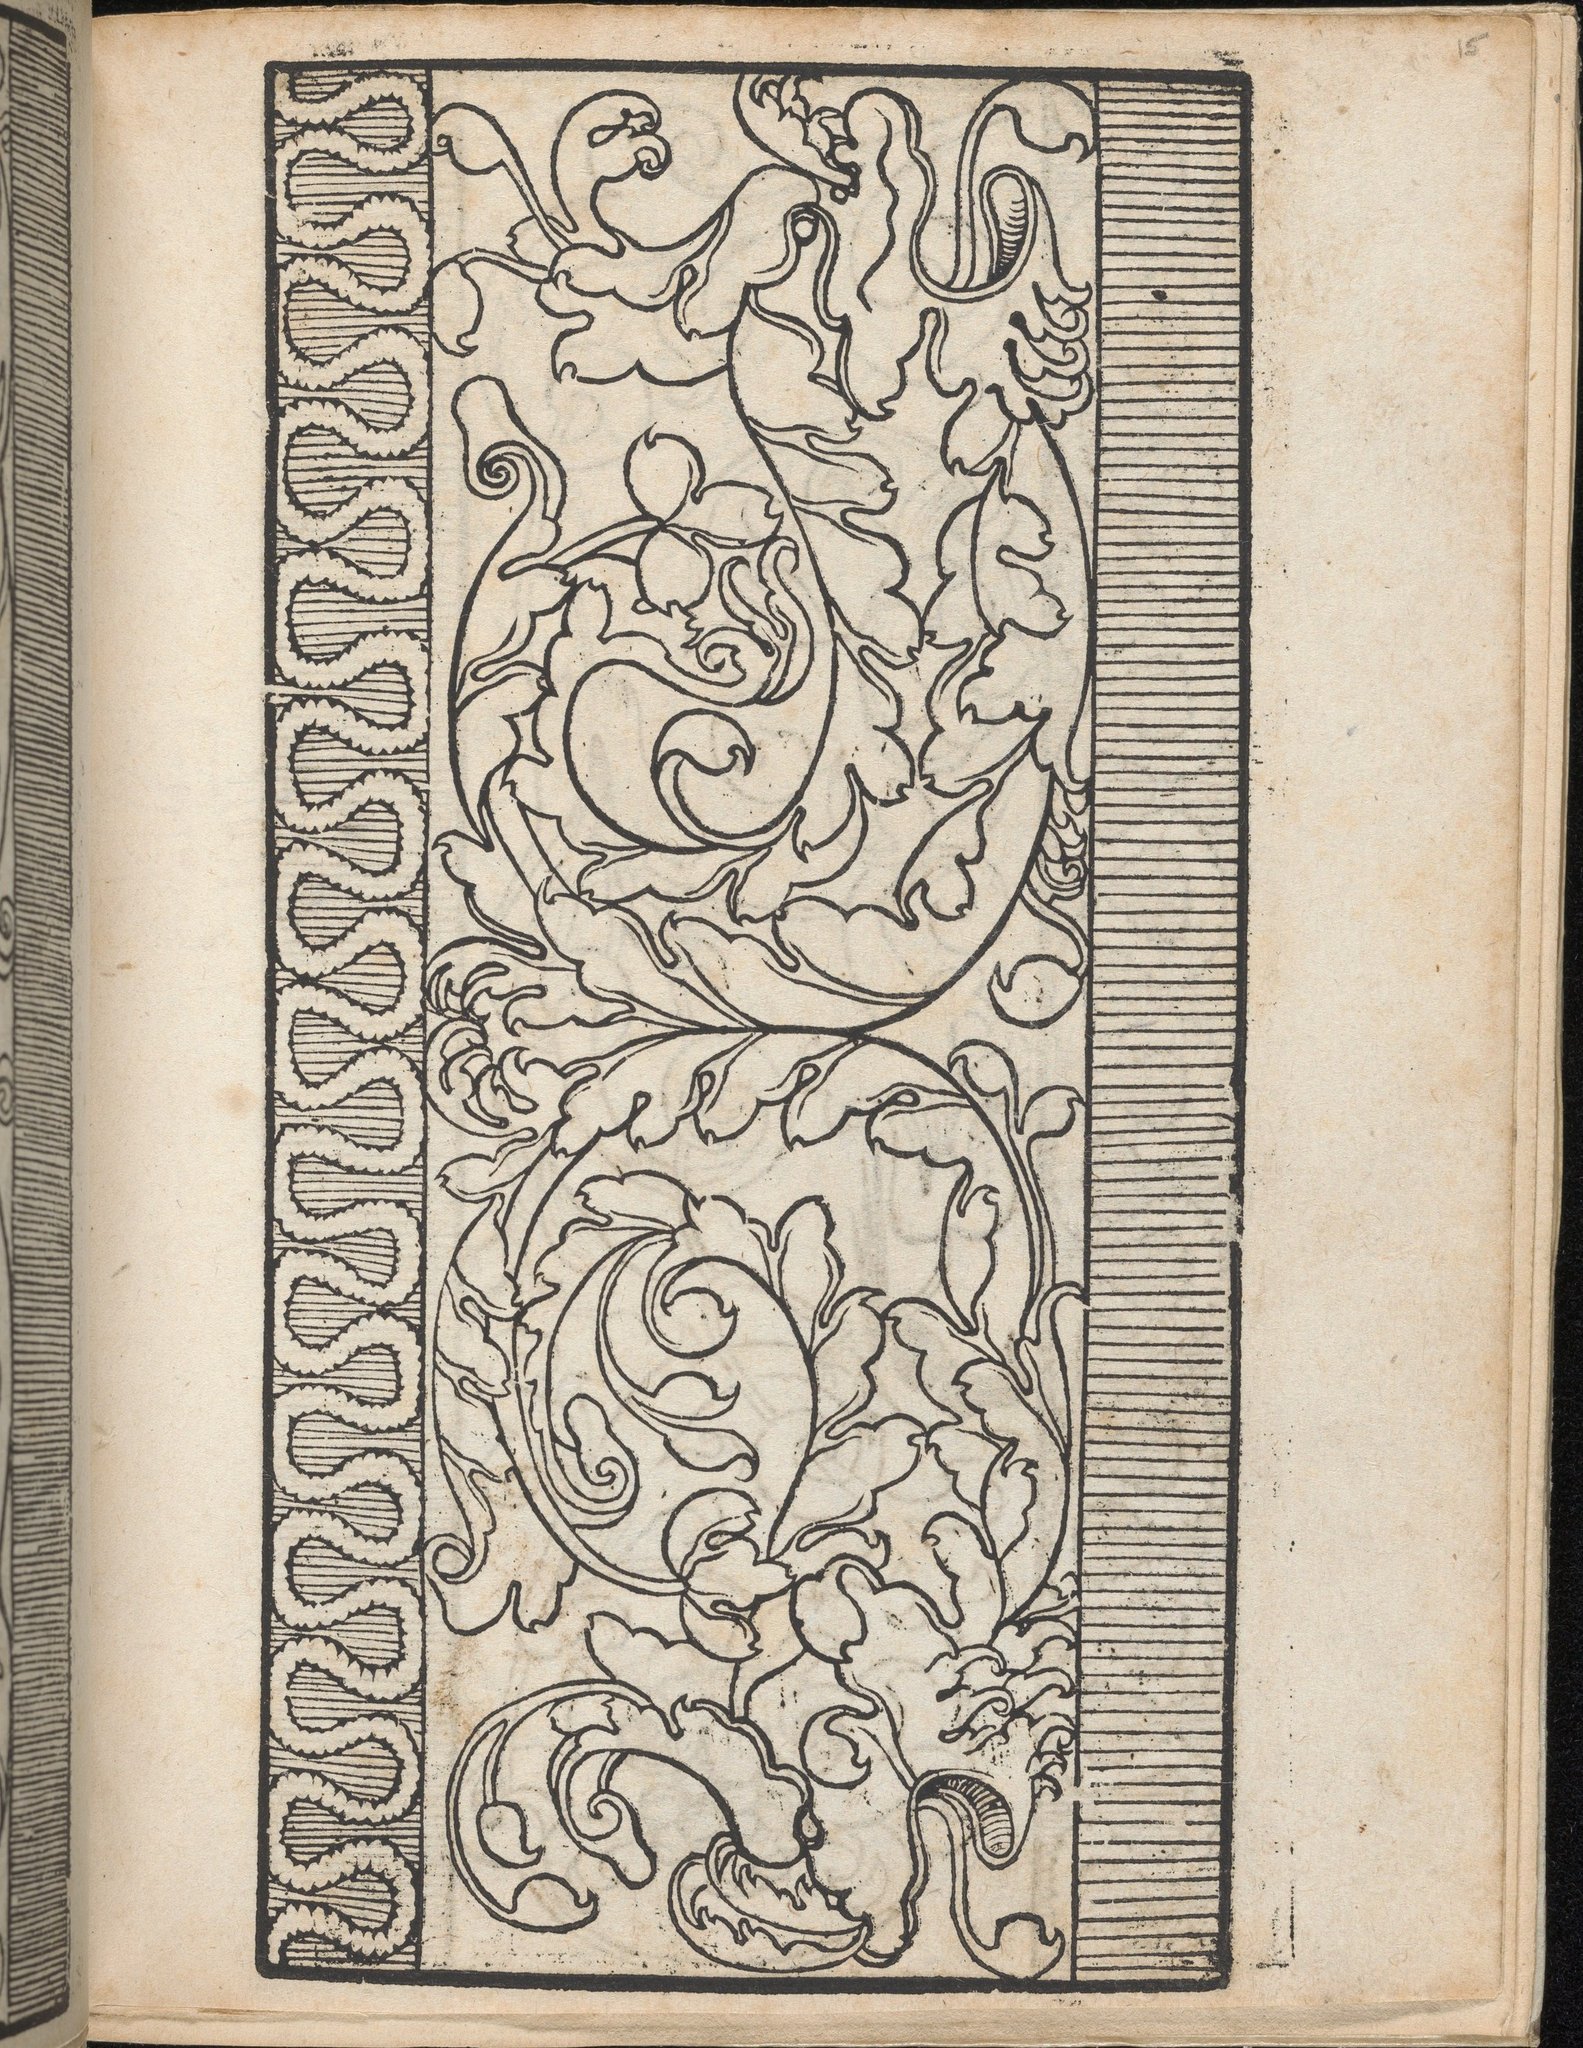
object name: book print ornament architecture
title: Ein new Modelbuch..., page 15 (recto)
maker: johann schönsperger the younger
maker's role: publisher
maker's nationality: german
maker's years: 1490-1550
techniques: woodcut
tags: acanthus